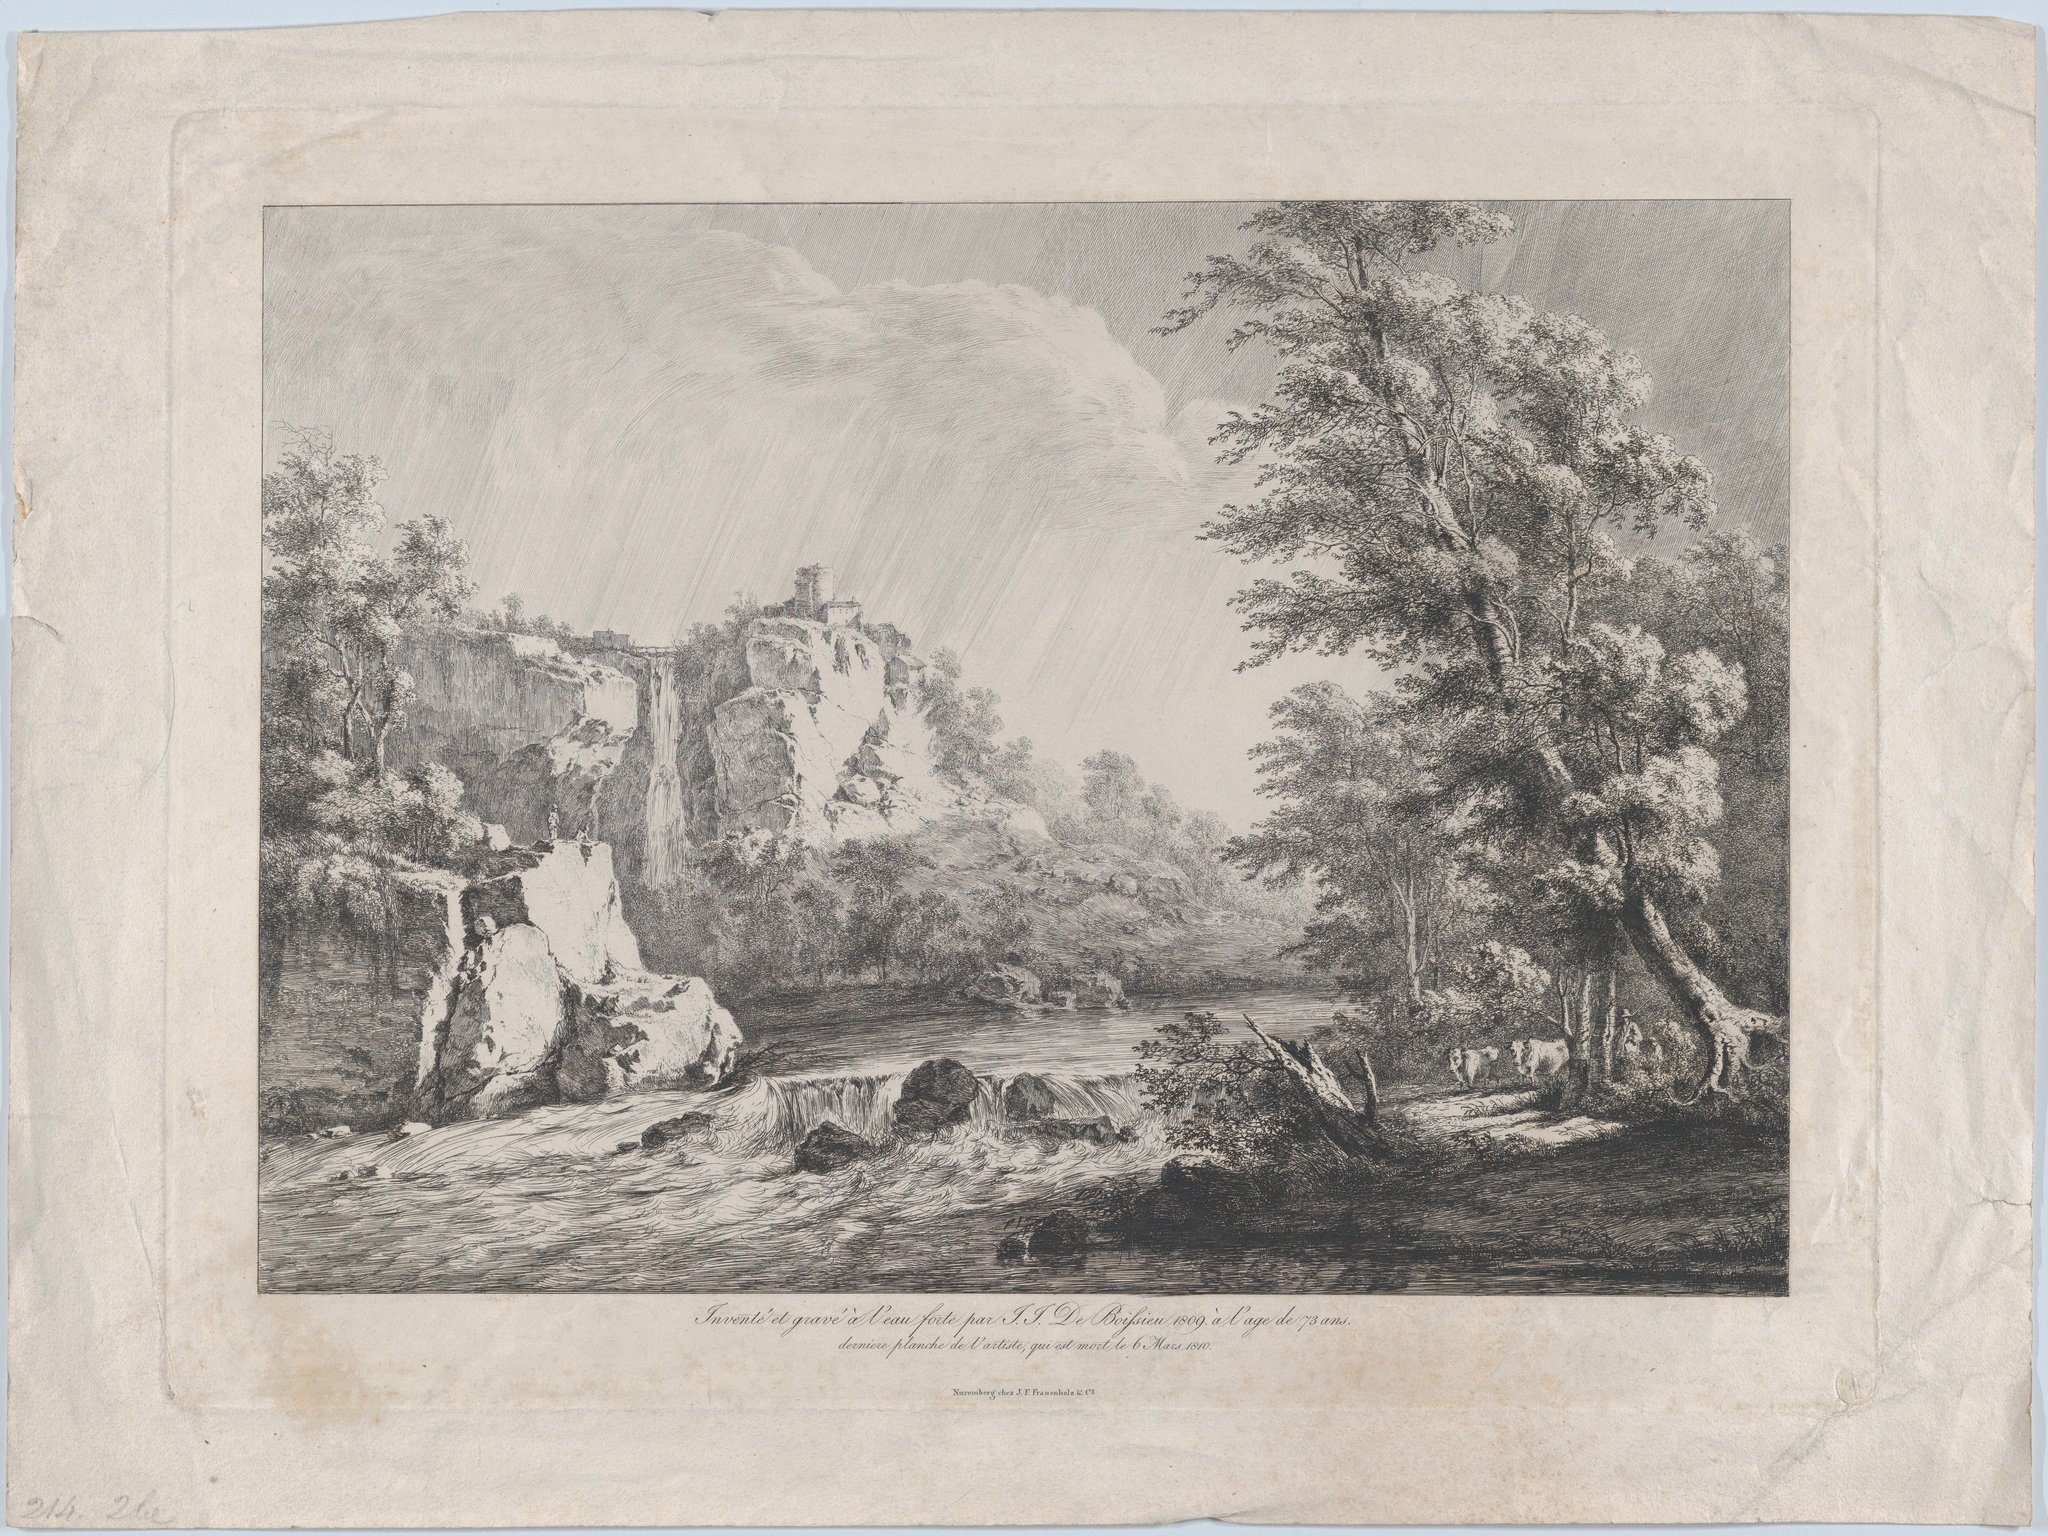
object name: print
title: Birch Tree Uprooted by a Storm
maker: jean jacques de boissieu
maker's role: artist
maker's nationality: french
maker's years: 1736-1810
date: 1809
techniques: drypoint, etching, roulette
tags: cows,rivers,landscapes